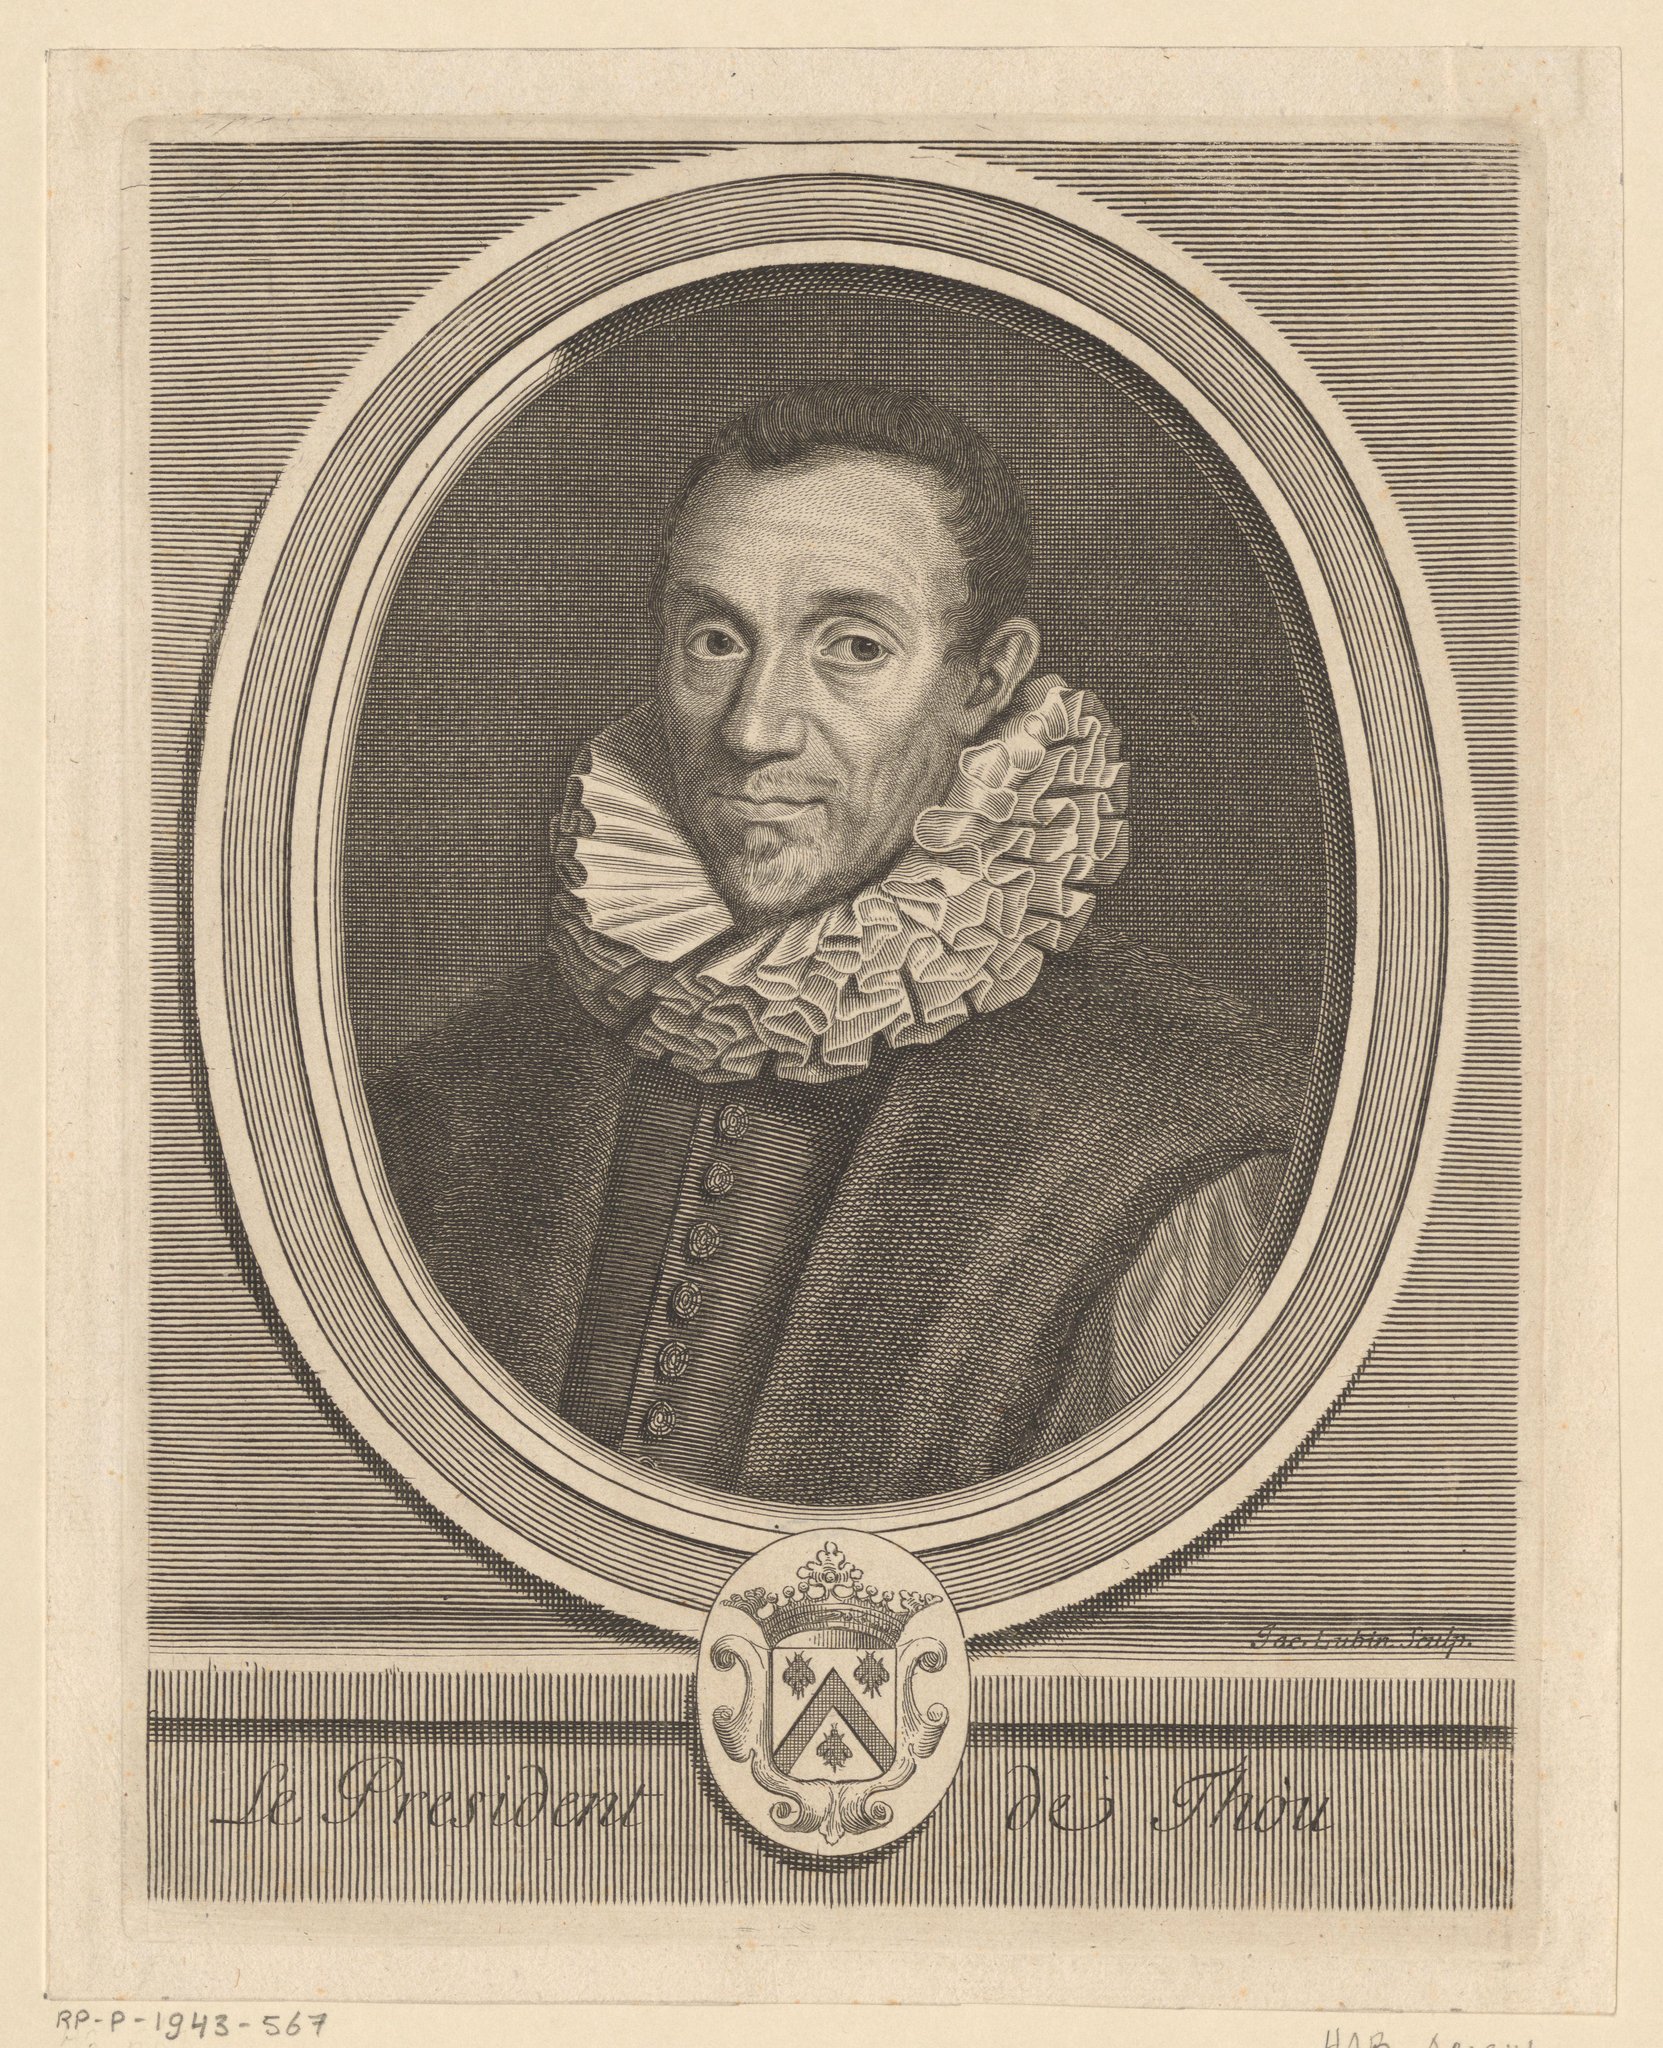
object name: print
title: Portret van Jacques-Auguste de Thou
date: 1696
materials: paper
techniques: engraving, etching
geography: paris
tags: paris, politician, historical persons, portrait of a writer, armorial bearing, heraldry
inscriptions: collector's mark: Lugt 2228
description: Prent uit: Perrault, Charles. Les hommes illustres qui ont paru en France pendant ce siècle. Parijs: Antoine Dezallier, 1696.